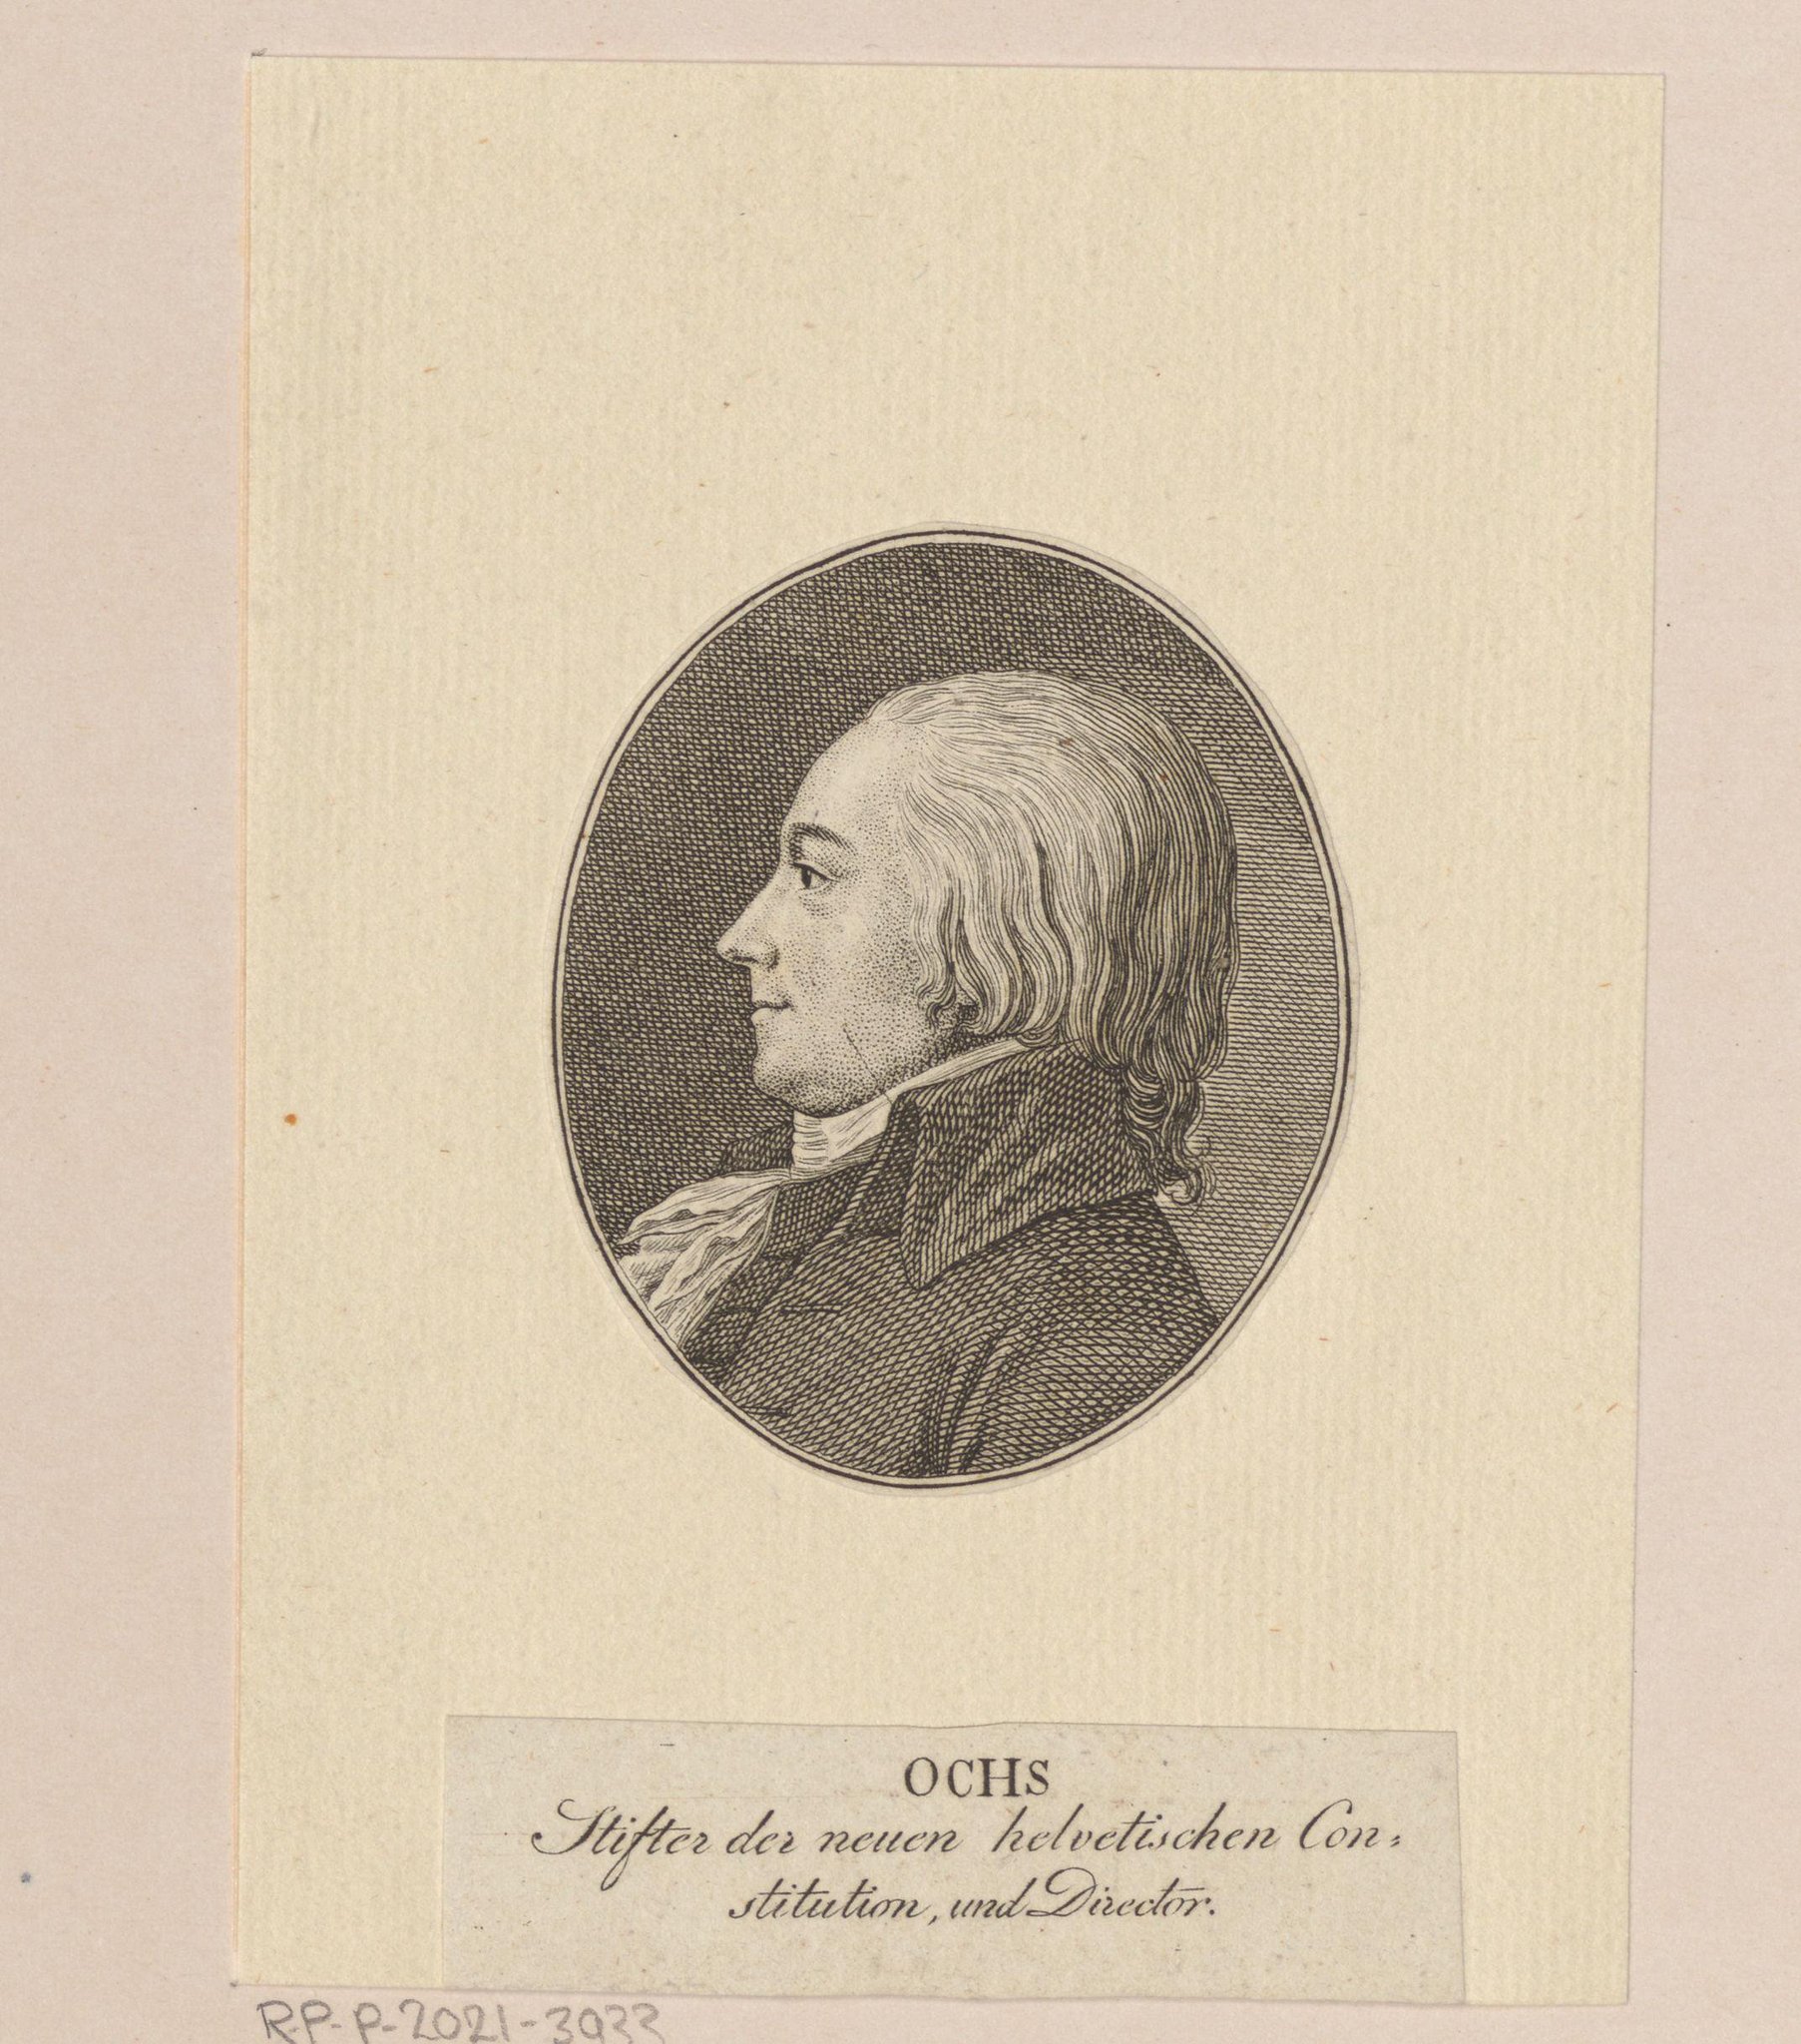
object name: print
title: Portret van Peter Ochs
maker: Anonymous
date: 1799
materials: paper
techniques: engraving, etching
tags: historical persons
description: Prent mogelijk uit: Revolutions-Almanach von 1799. Göttingen: Johann Christian Dieterich, 1799.